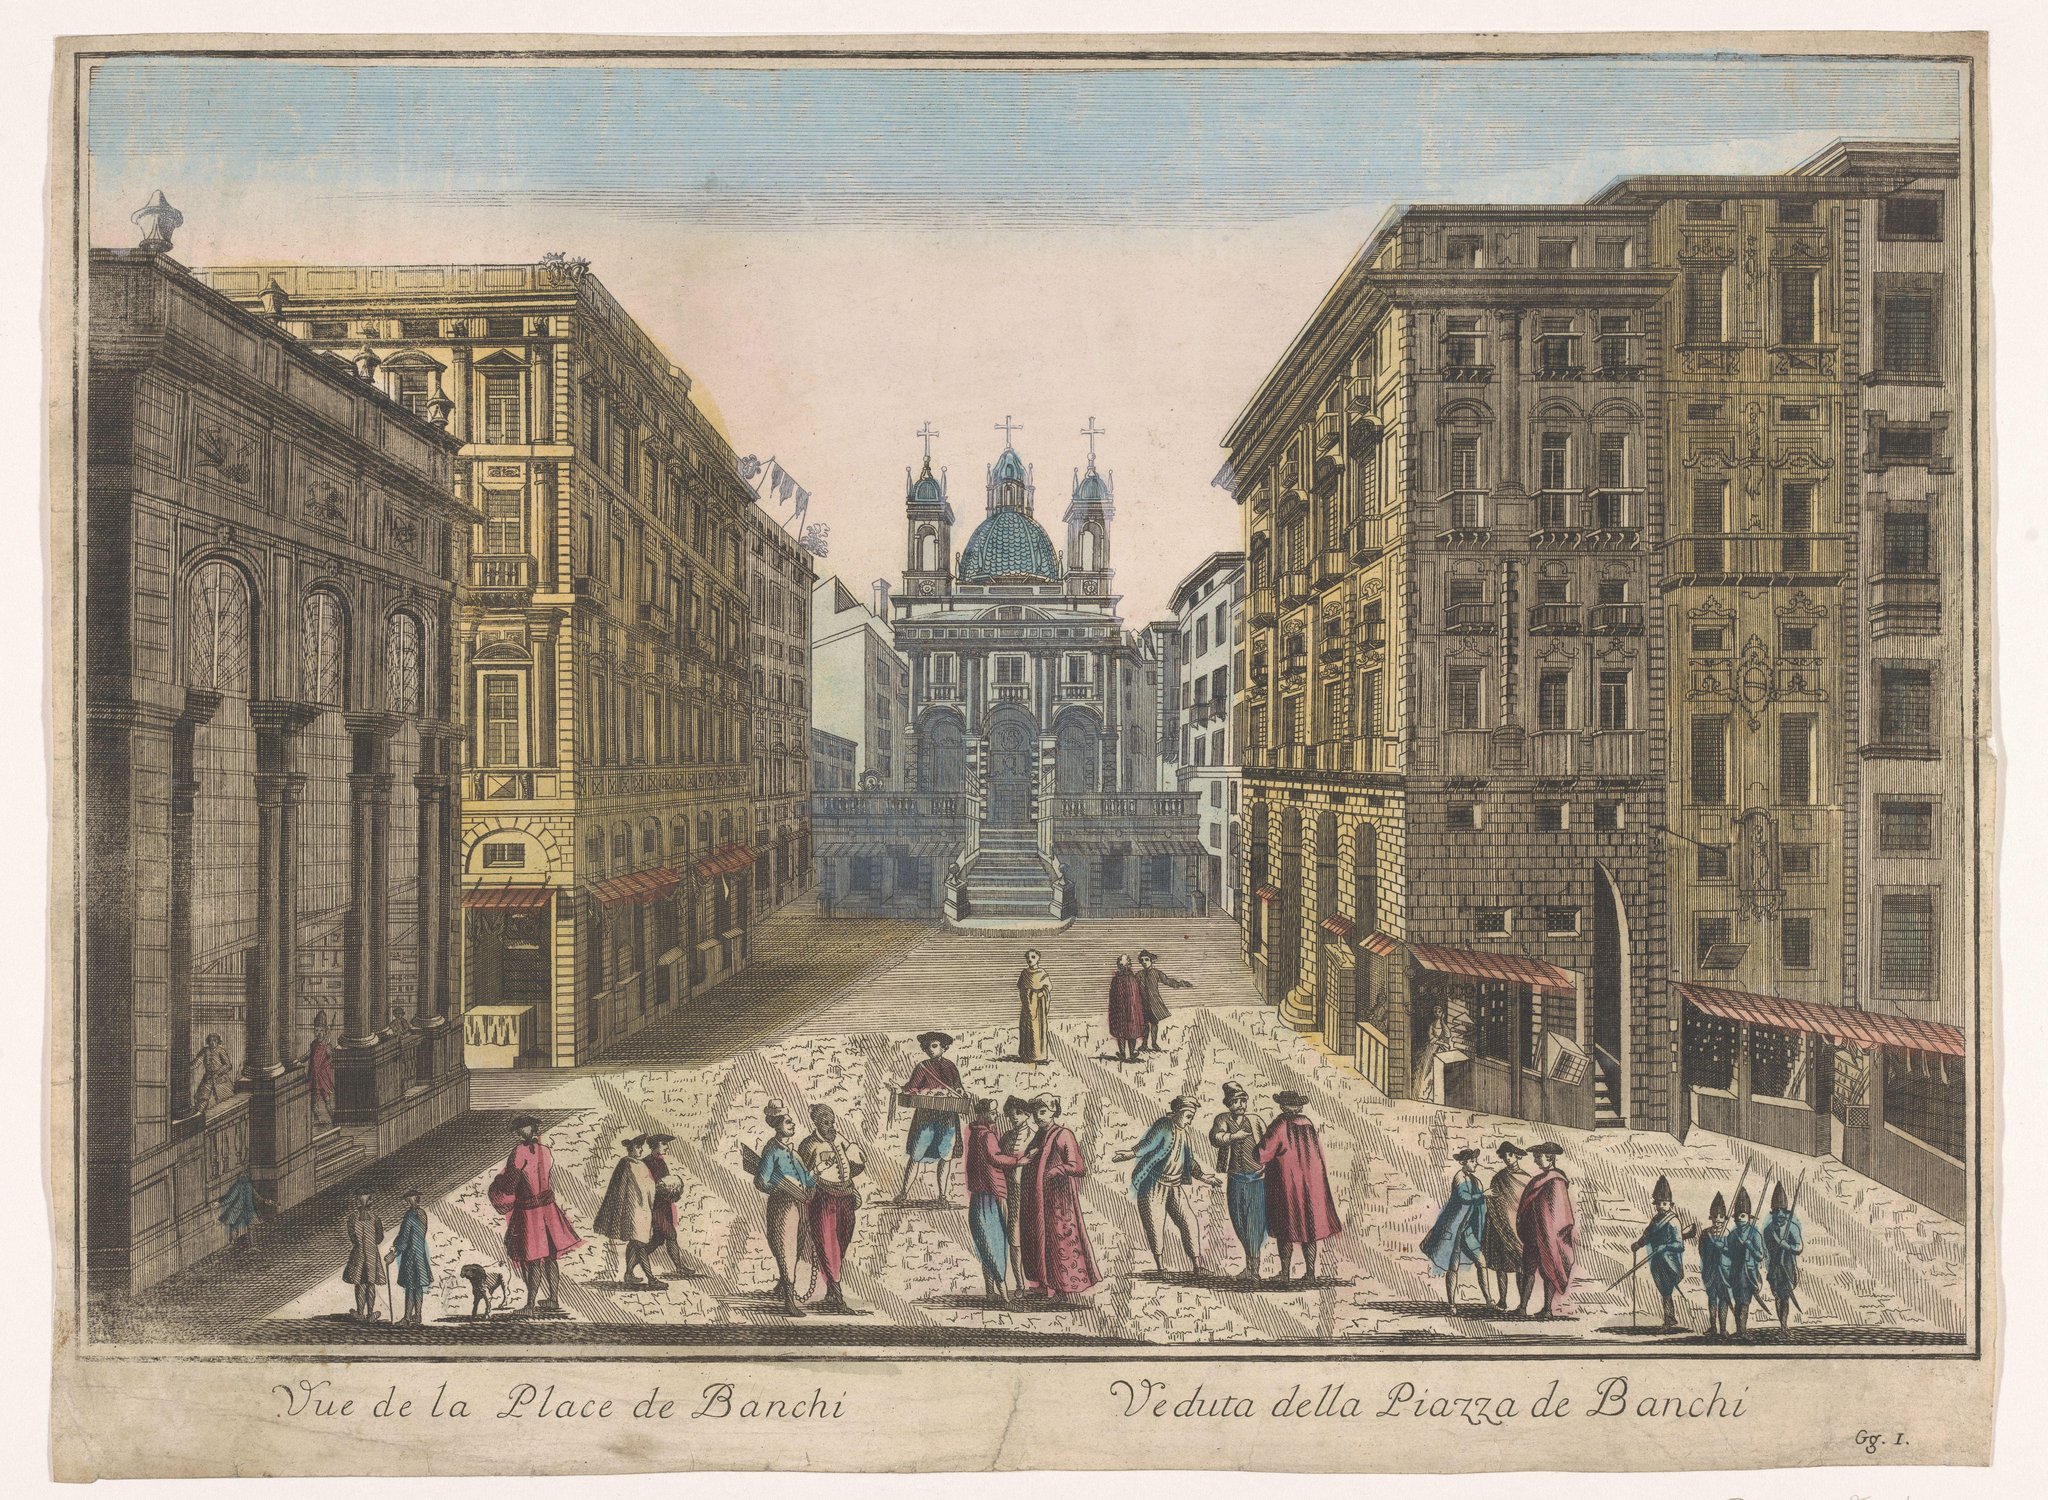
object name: print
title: Gezicht op het Piazza Banchi te Genua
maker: Anonymous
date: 1700-1799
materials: paper, watercolor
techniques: brush, etching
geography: italy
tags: church (exterior), square, place, circus, etc. (+ city(-scape) with figures, staffage)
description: In het midden de kerk San Pietro in Banchi. Rechtsonder genummerd: Gg 1.